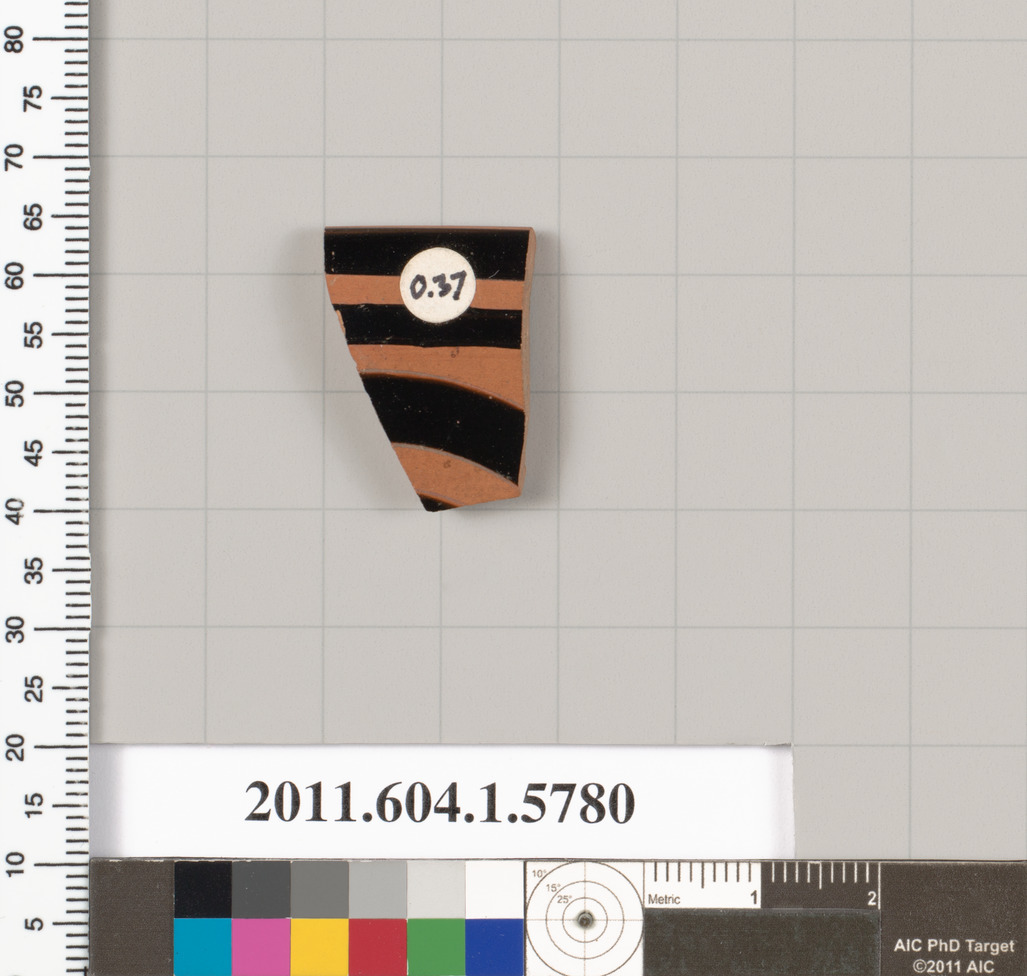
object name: kylix fragment, eye cup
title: Terracotta rim fragment of a kylix: eye-cup (drinking cup)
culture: greek, attic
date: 525-515 BCE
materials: terracotta